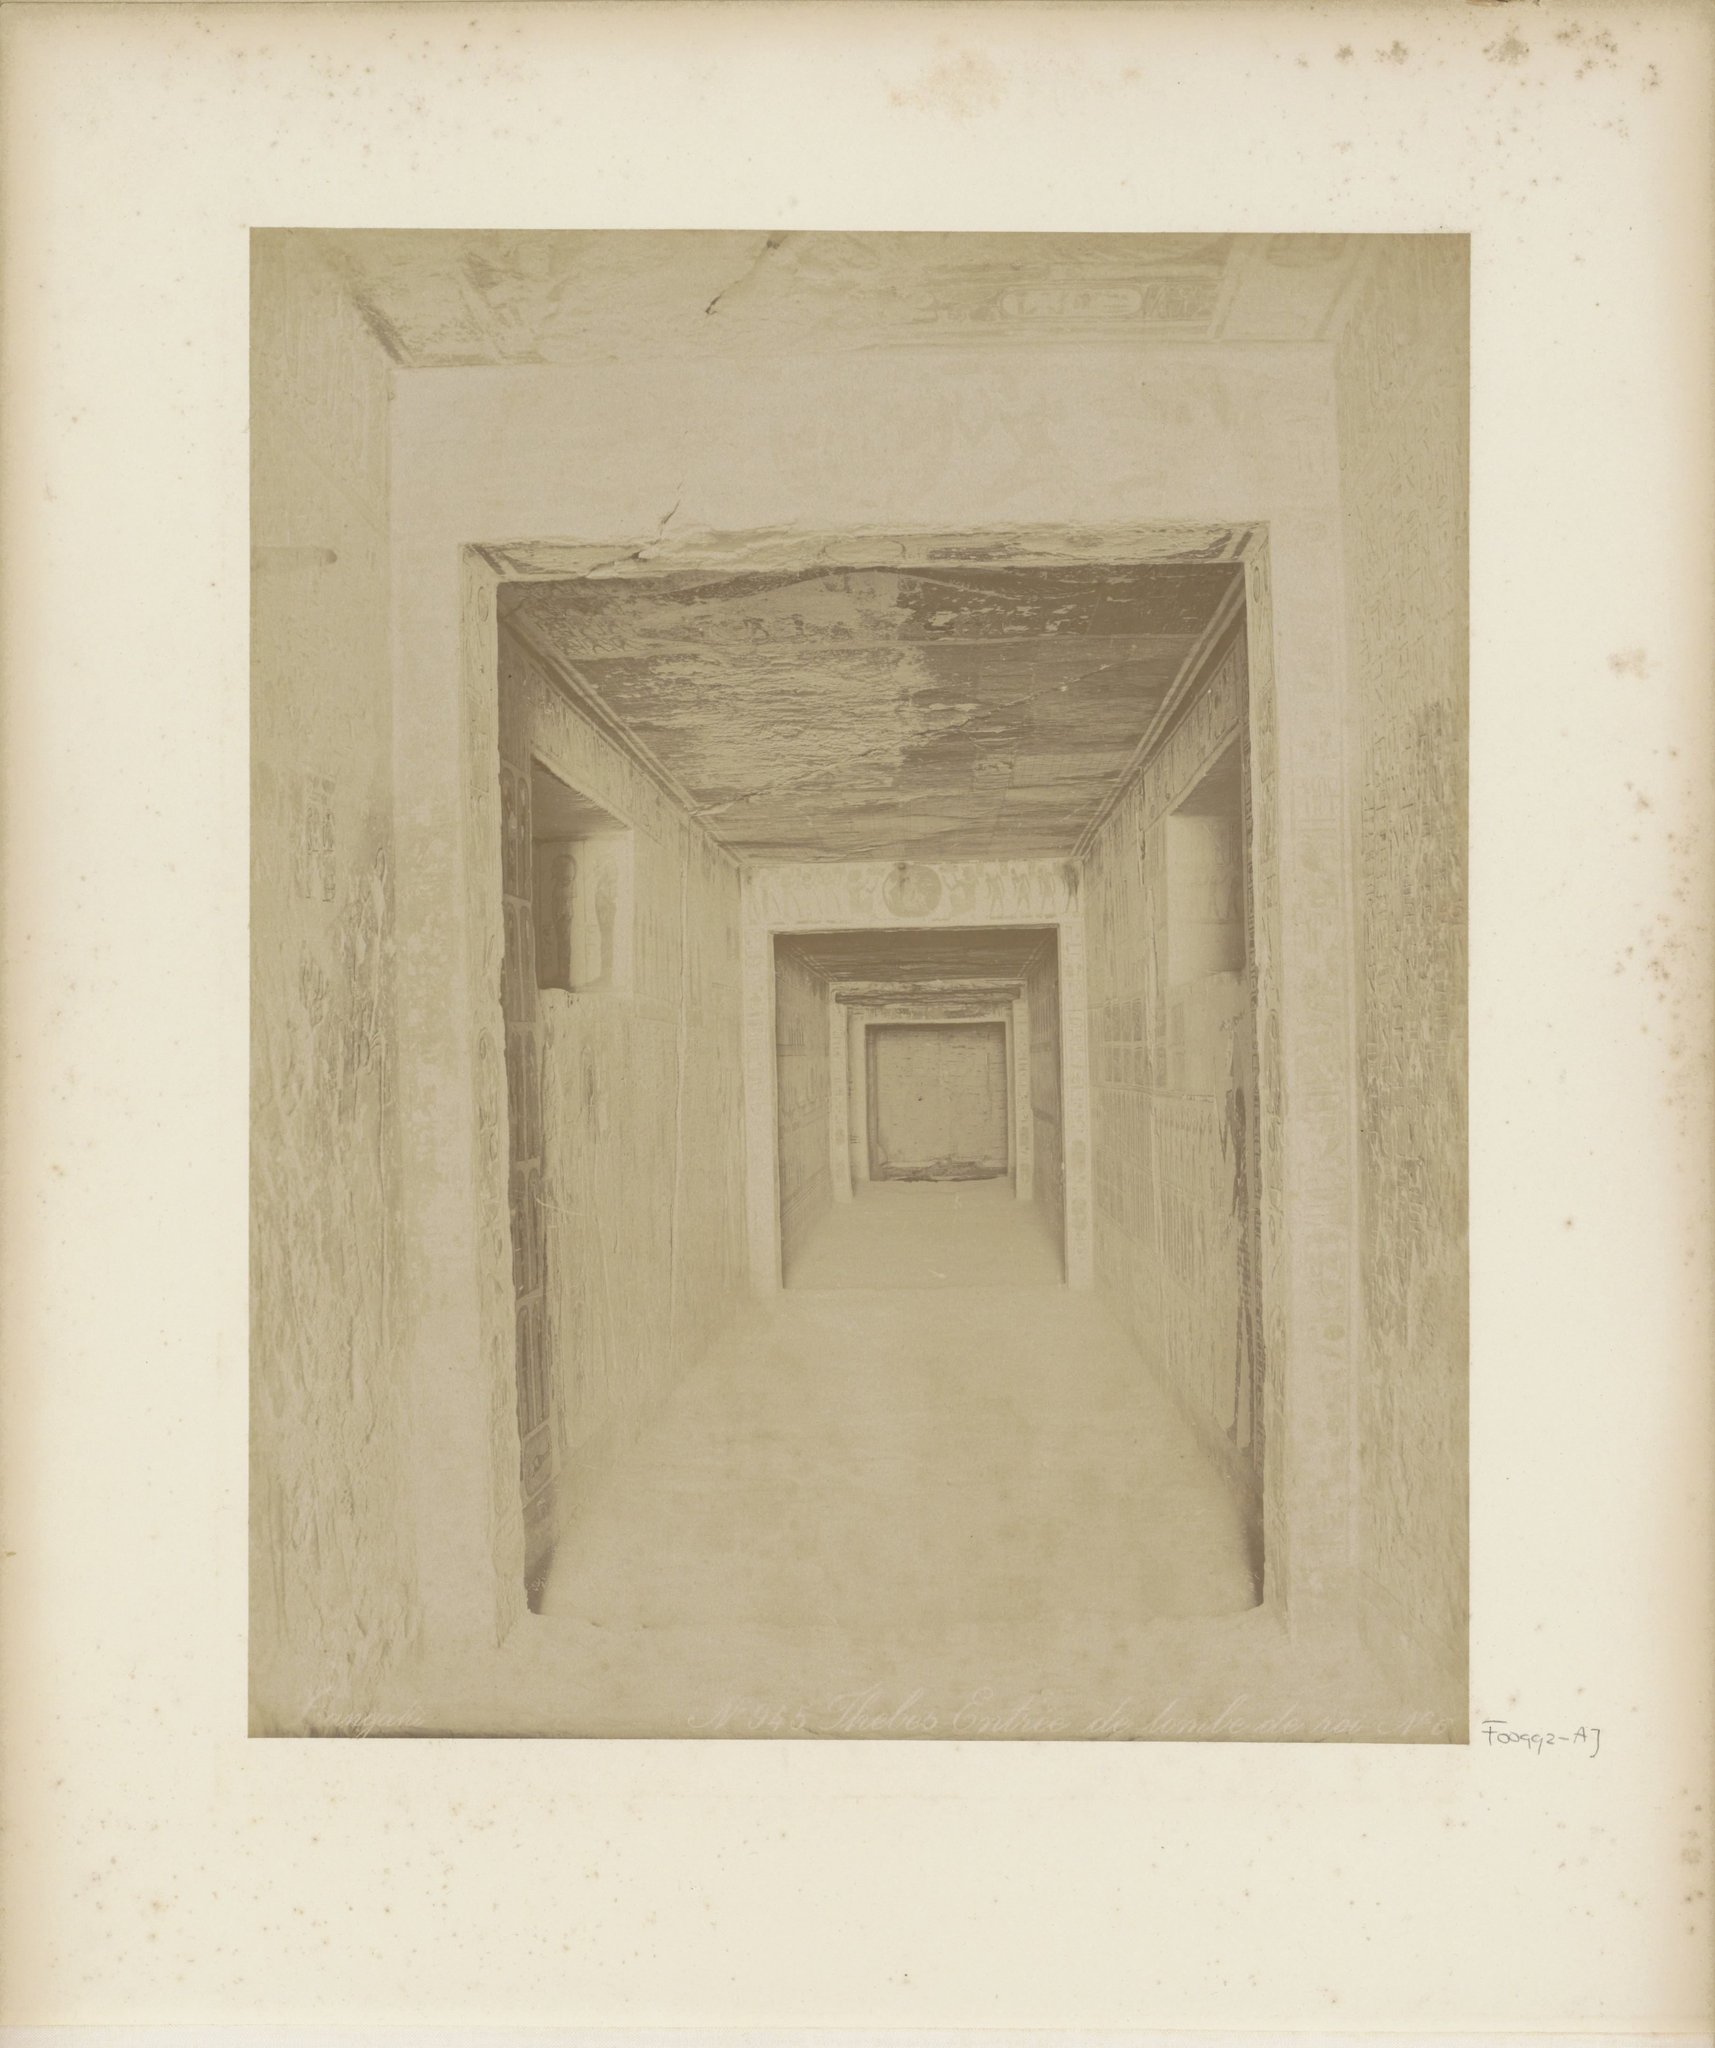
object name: photograph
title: Thebes Entrée de tombe de roi N. 6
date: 1870-1890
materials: cardboard, paper, photographic support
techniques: albumen print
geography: thebes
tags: grave-building, monumental tomb, thebes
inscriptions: negative number: ‘945’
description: Onderdeel van Reisalbum met 80 foto's van Egypte.